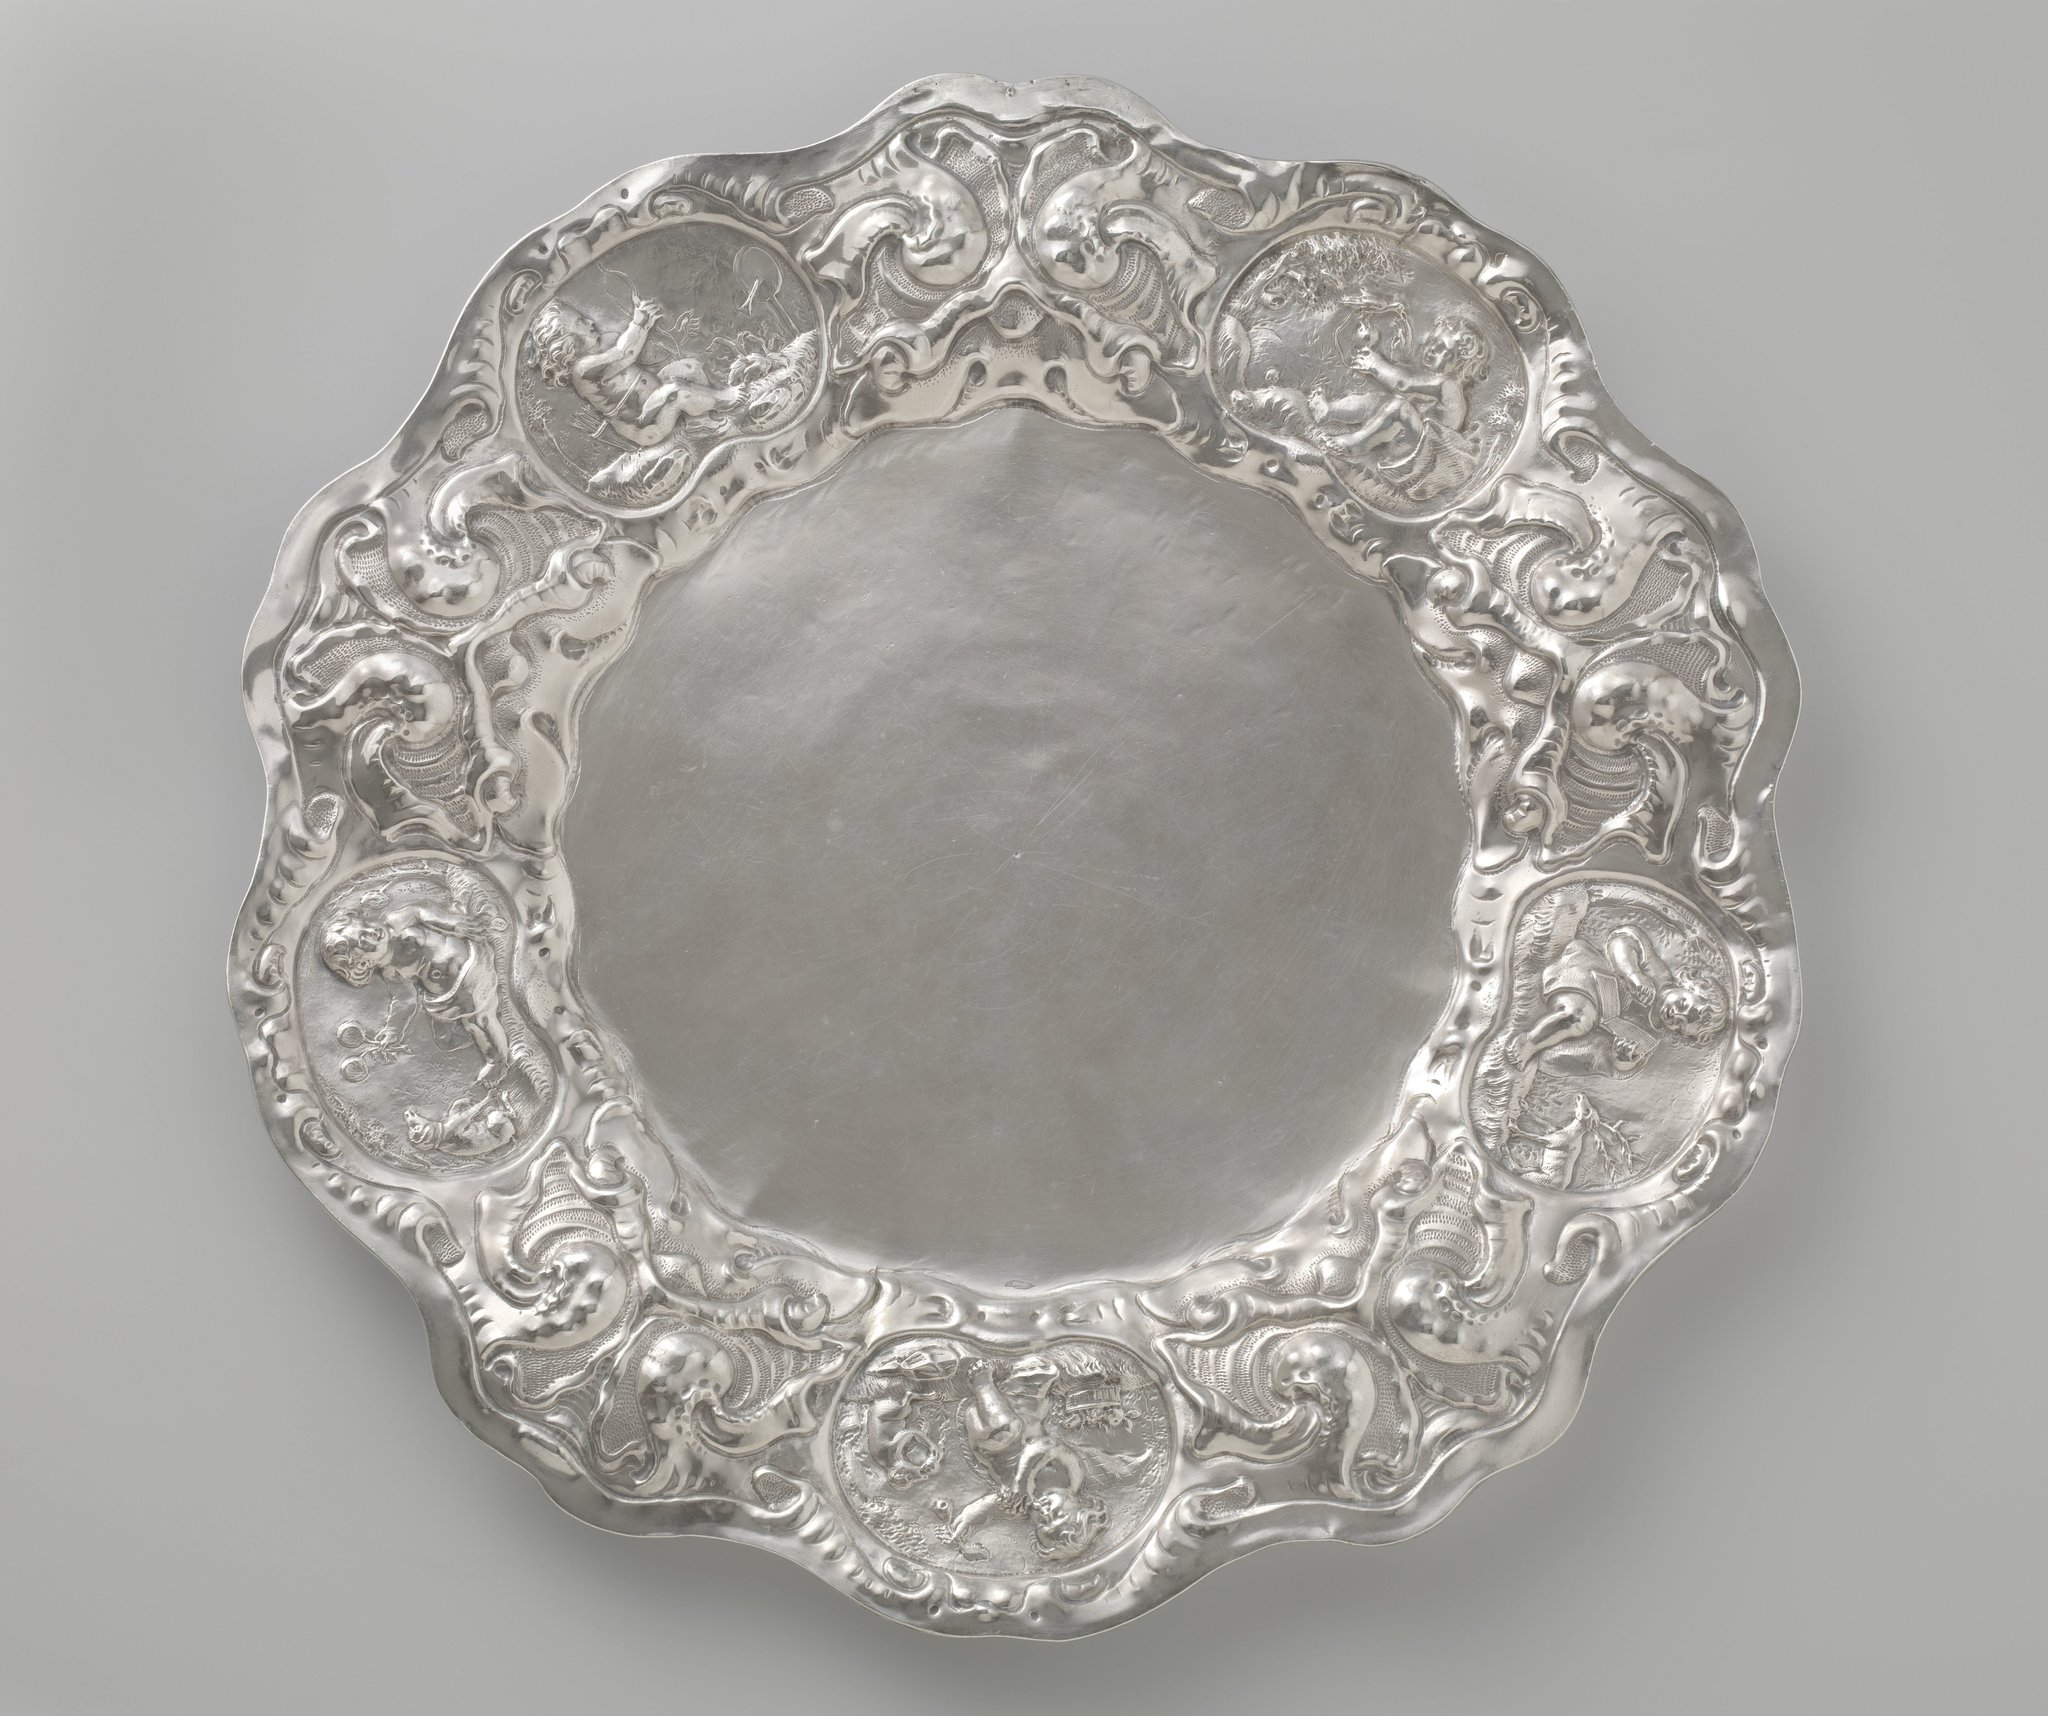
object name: dish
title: Schaal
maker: johannes grill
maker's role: silversmith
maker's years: 1614-1670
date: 1650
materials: silver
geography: amsterdam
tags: auricular ornament, lobe style ~ ornament, cupids: 'amores', 'amoretti', 'putti'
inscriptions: initials: ‘MDI’, town mark, maker's mark, date letter: ‘T’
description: Dish. Silver. Amsterdam, 1650, by Johannes Grill.